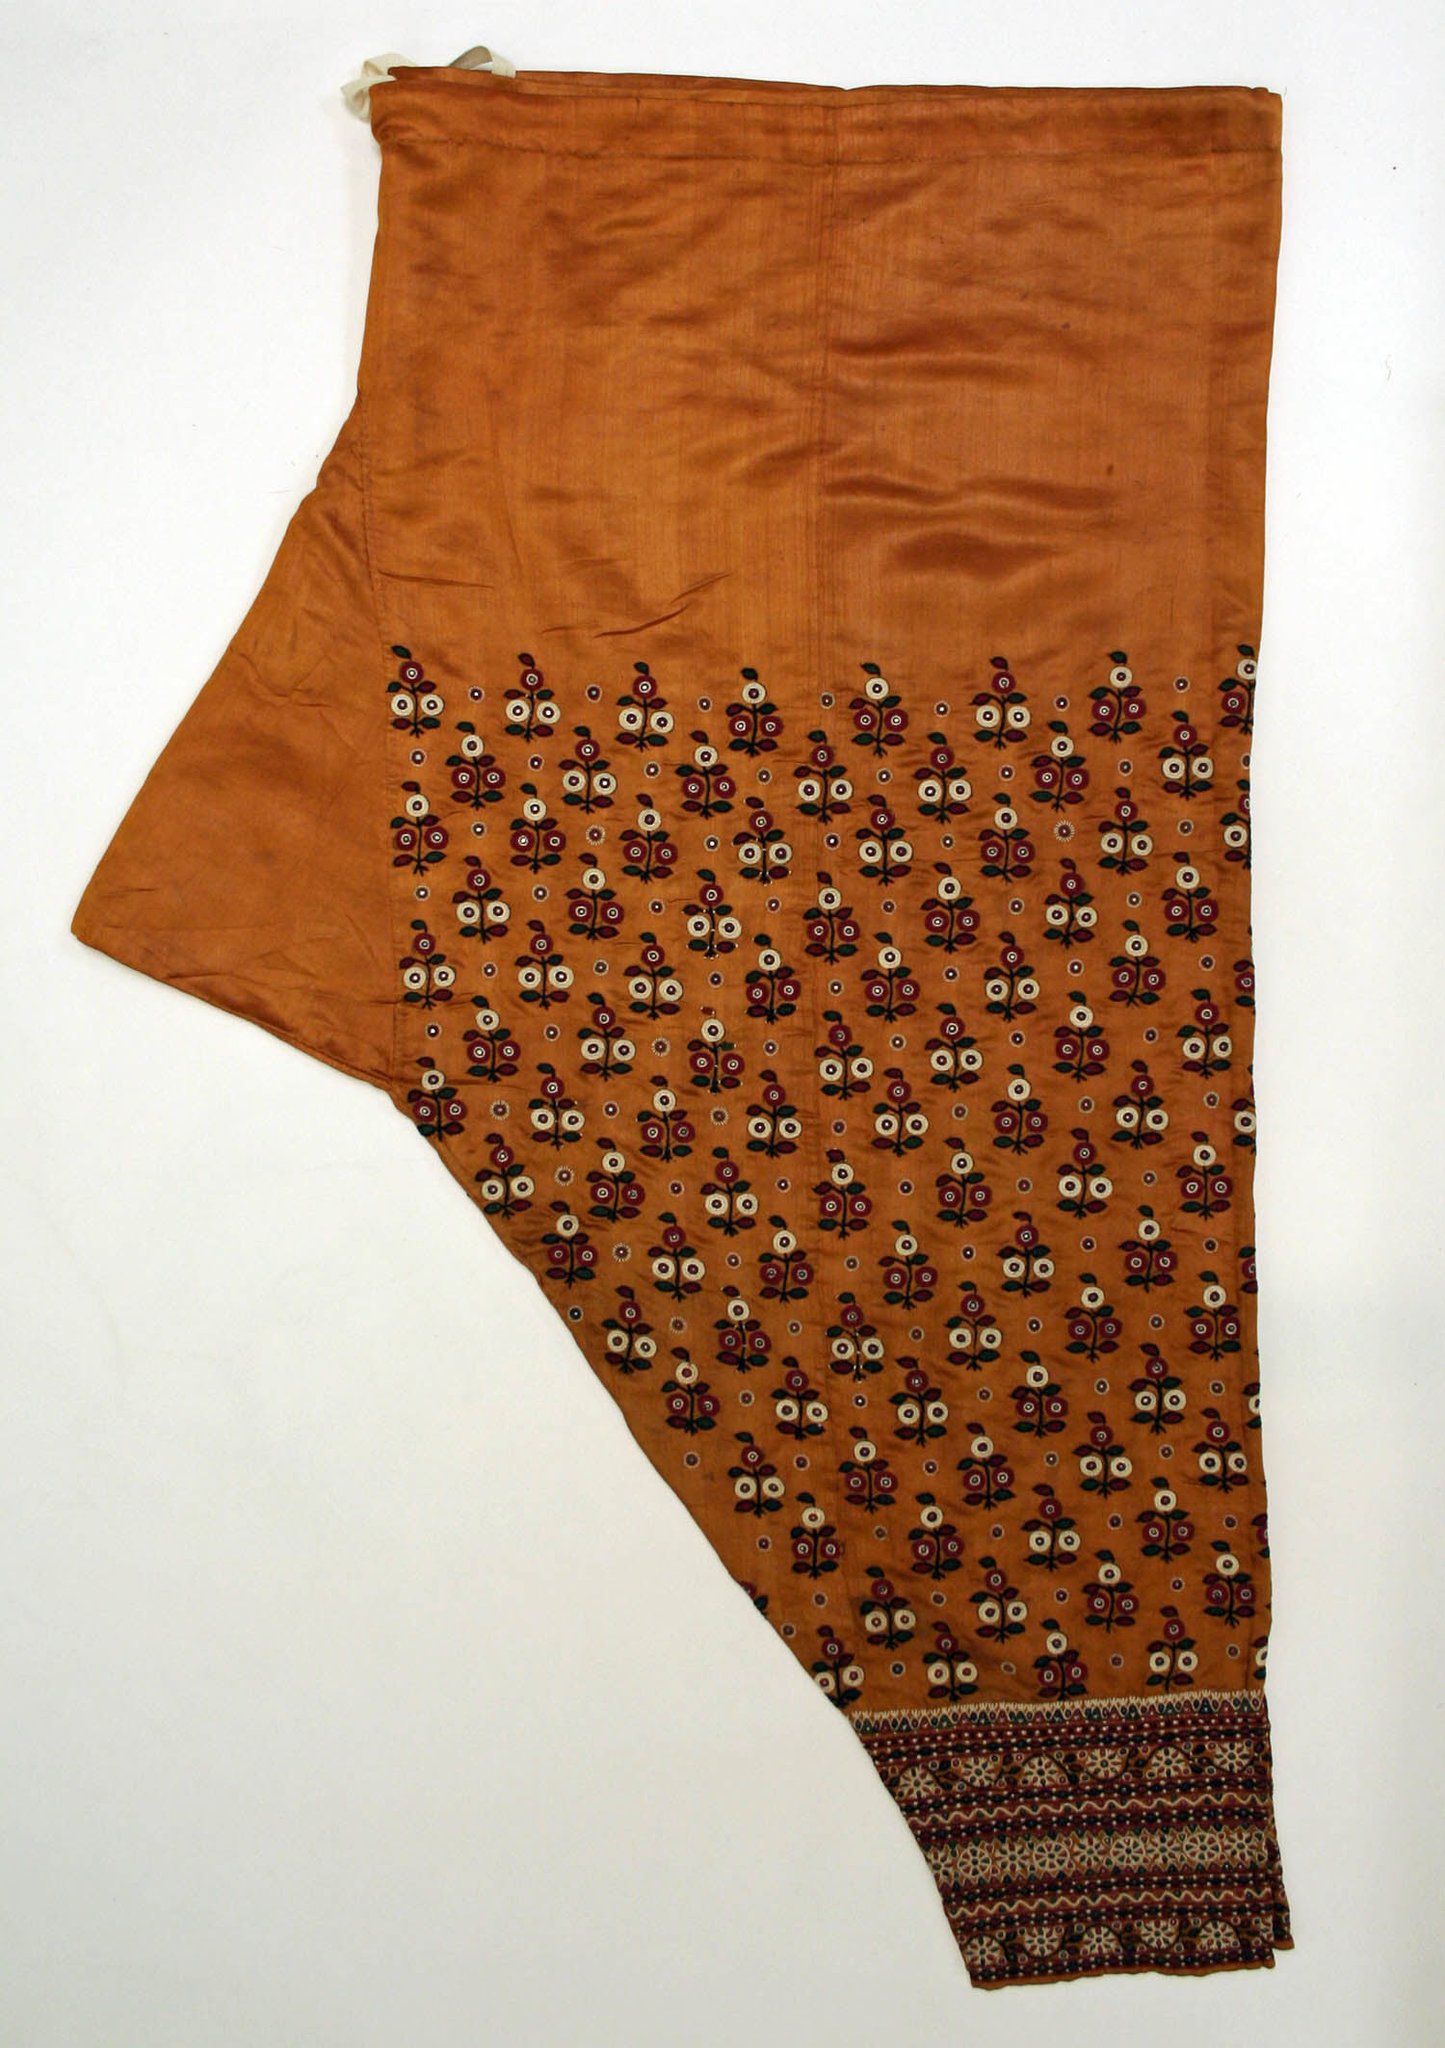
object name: trouser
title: Trousers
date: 1801-1900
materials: silk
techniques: embroidery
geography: india